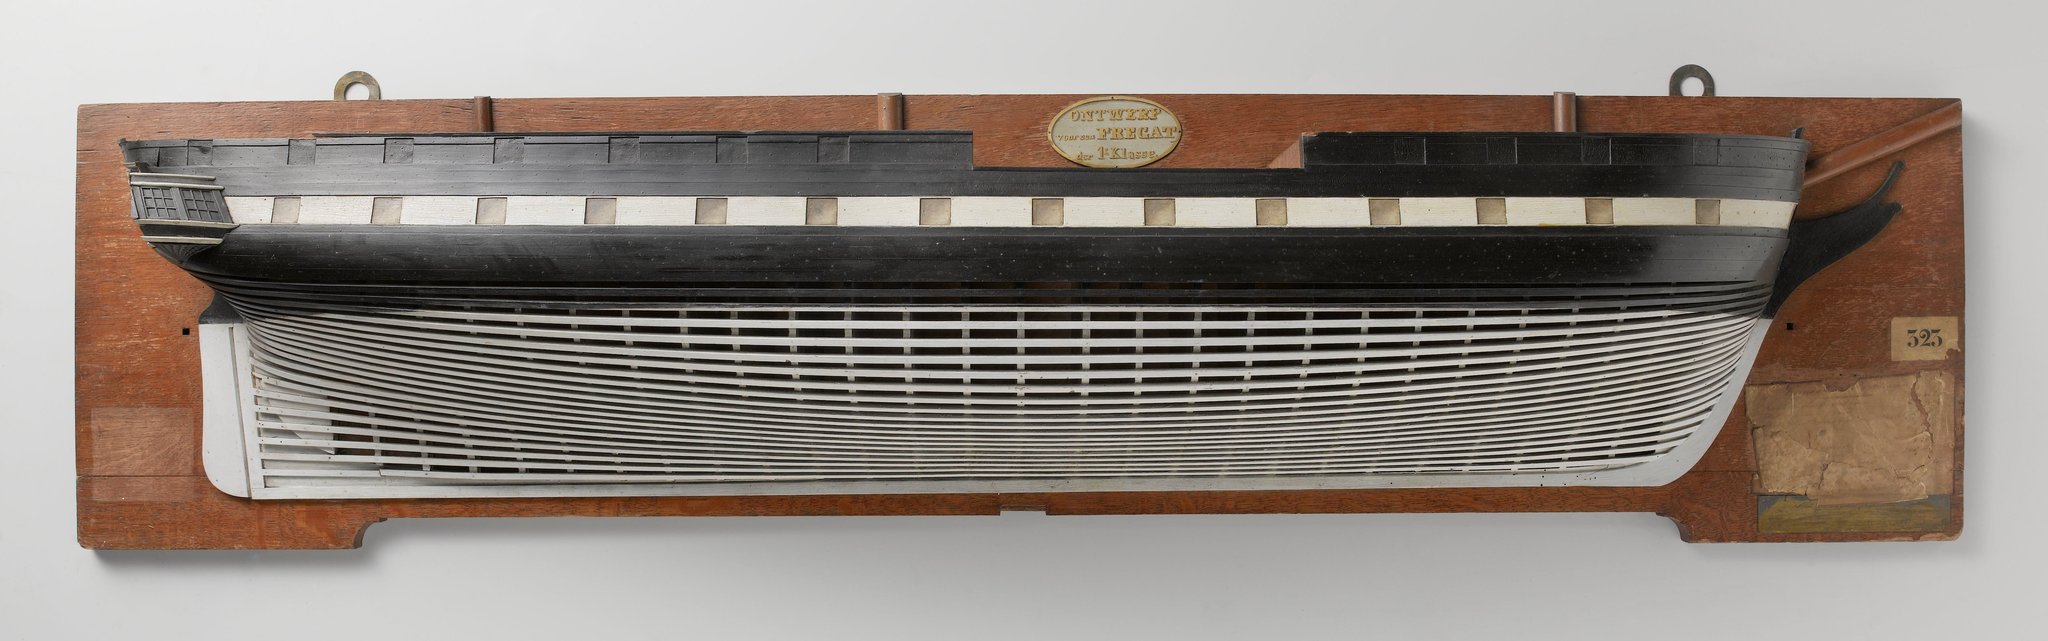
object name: half model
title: Half Model of a 50-Gun Frigate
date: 1843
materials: brass, wood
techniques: polychromy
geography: flushing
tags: de ruyter (schip)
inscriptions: inscription, top centre, on an oval label: ‘ONTWERP / voor een FREGAT / der 1e Klasse.’, label, bottom right: brass scale in inches, label, centre right: ‘323’ former inventory label, inscription, bottom right, on a piece of paper, in ink: ‘Algemene bepalingen / [followed by measurements and armament]’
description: Gepolychromeerd mallenmodel (stuurboord) van een driemaster. Acht en twintig geschutpoorten op twee dekken. Achterschip met elliptisch hek en versierde zijgalerij van één verdieping, daarboven een open dek; roer met ronde roerkoning (Soetermeers versie) en roerblad onderaan afgerond. De zeeg is bijna vlak, één barkhout. Gepiekt rondspant. Schaal 1:50 (schaal op model).